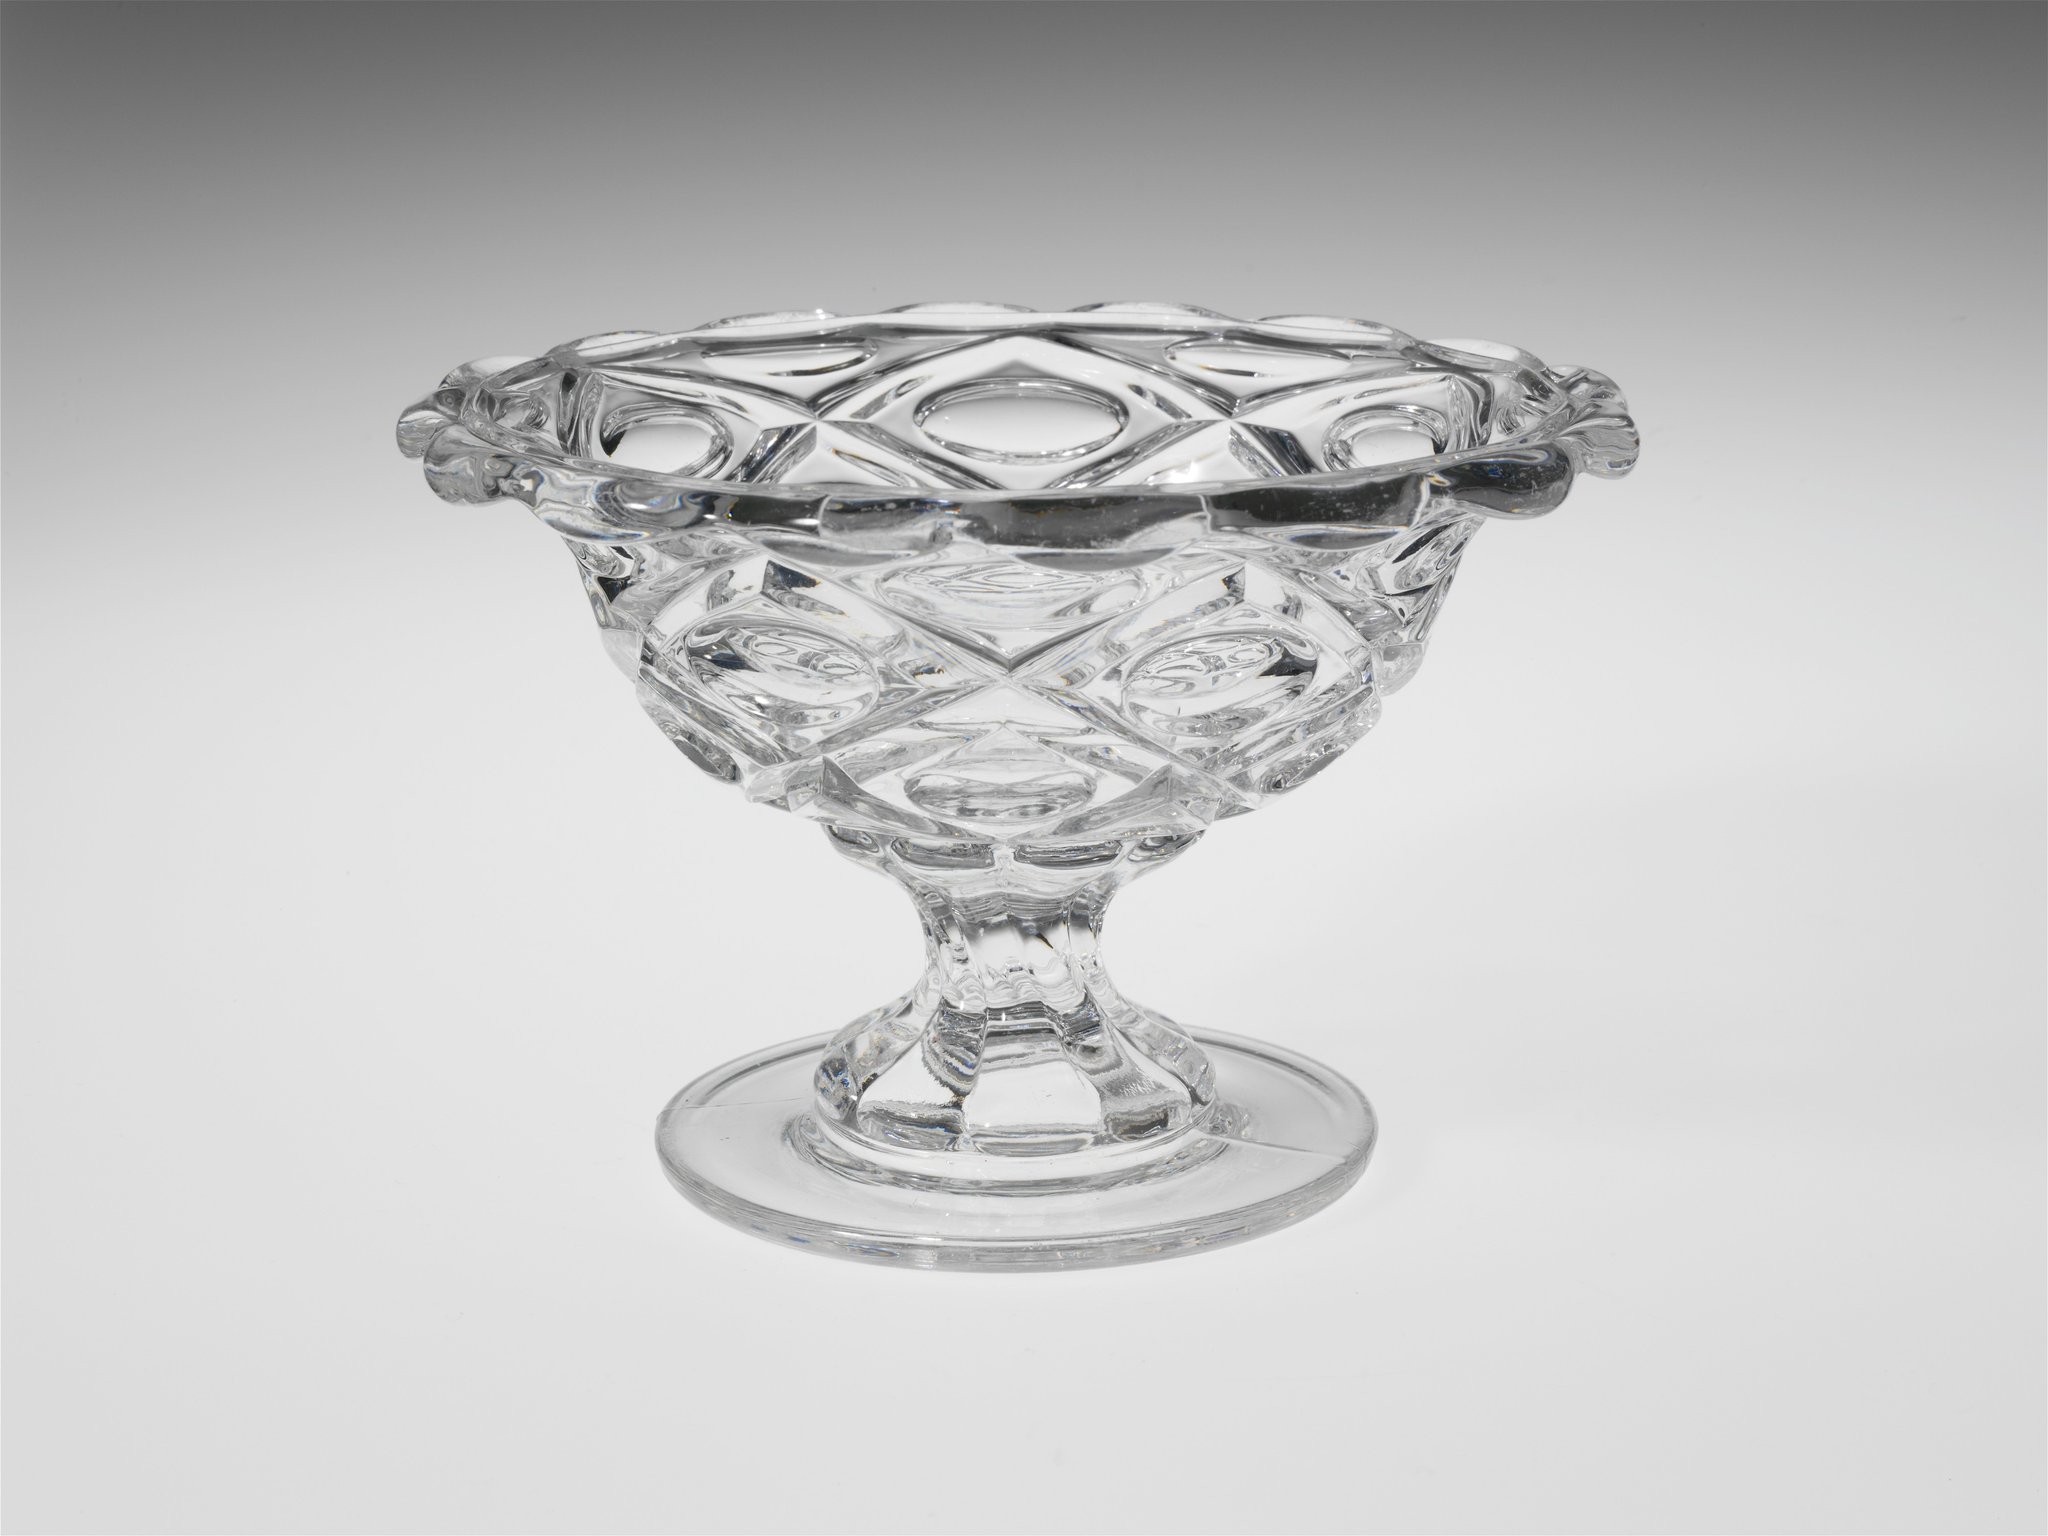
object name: bowl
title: Footed Bowl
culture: american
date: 1850-1870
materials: glass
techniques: pressed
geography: united states